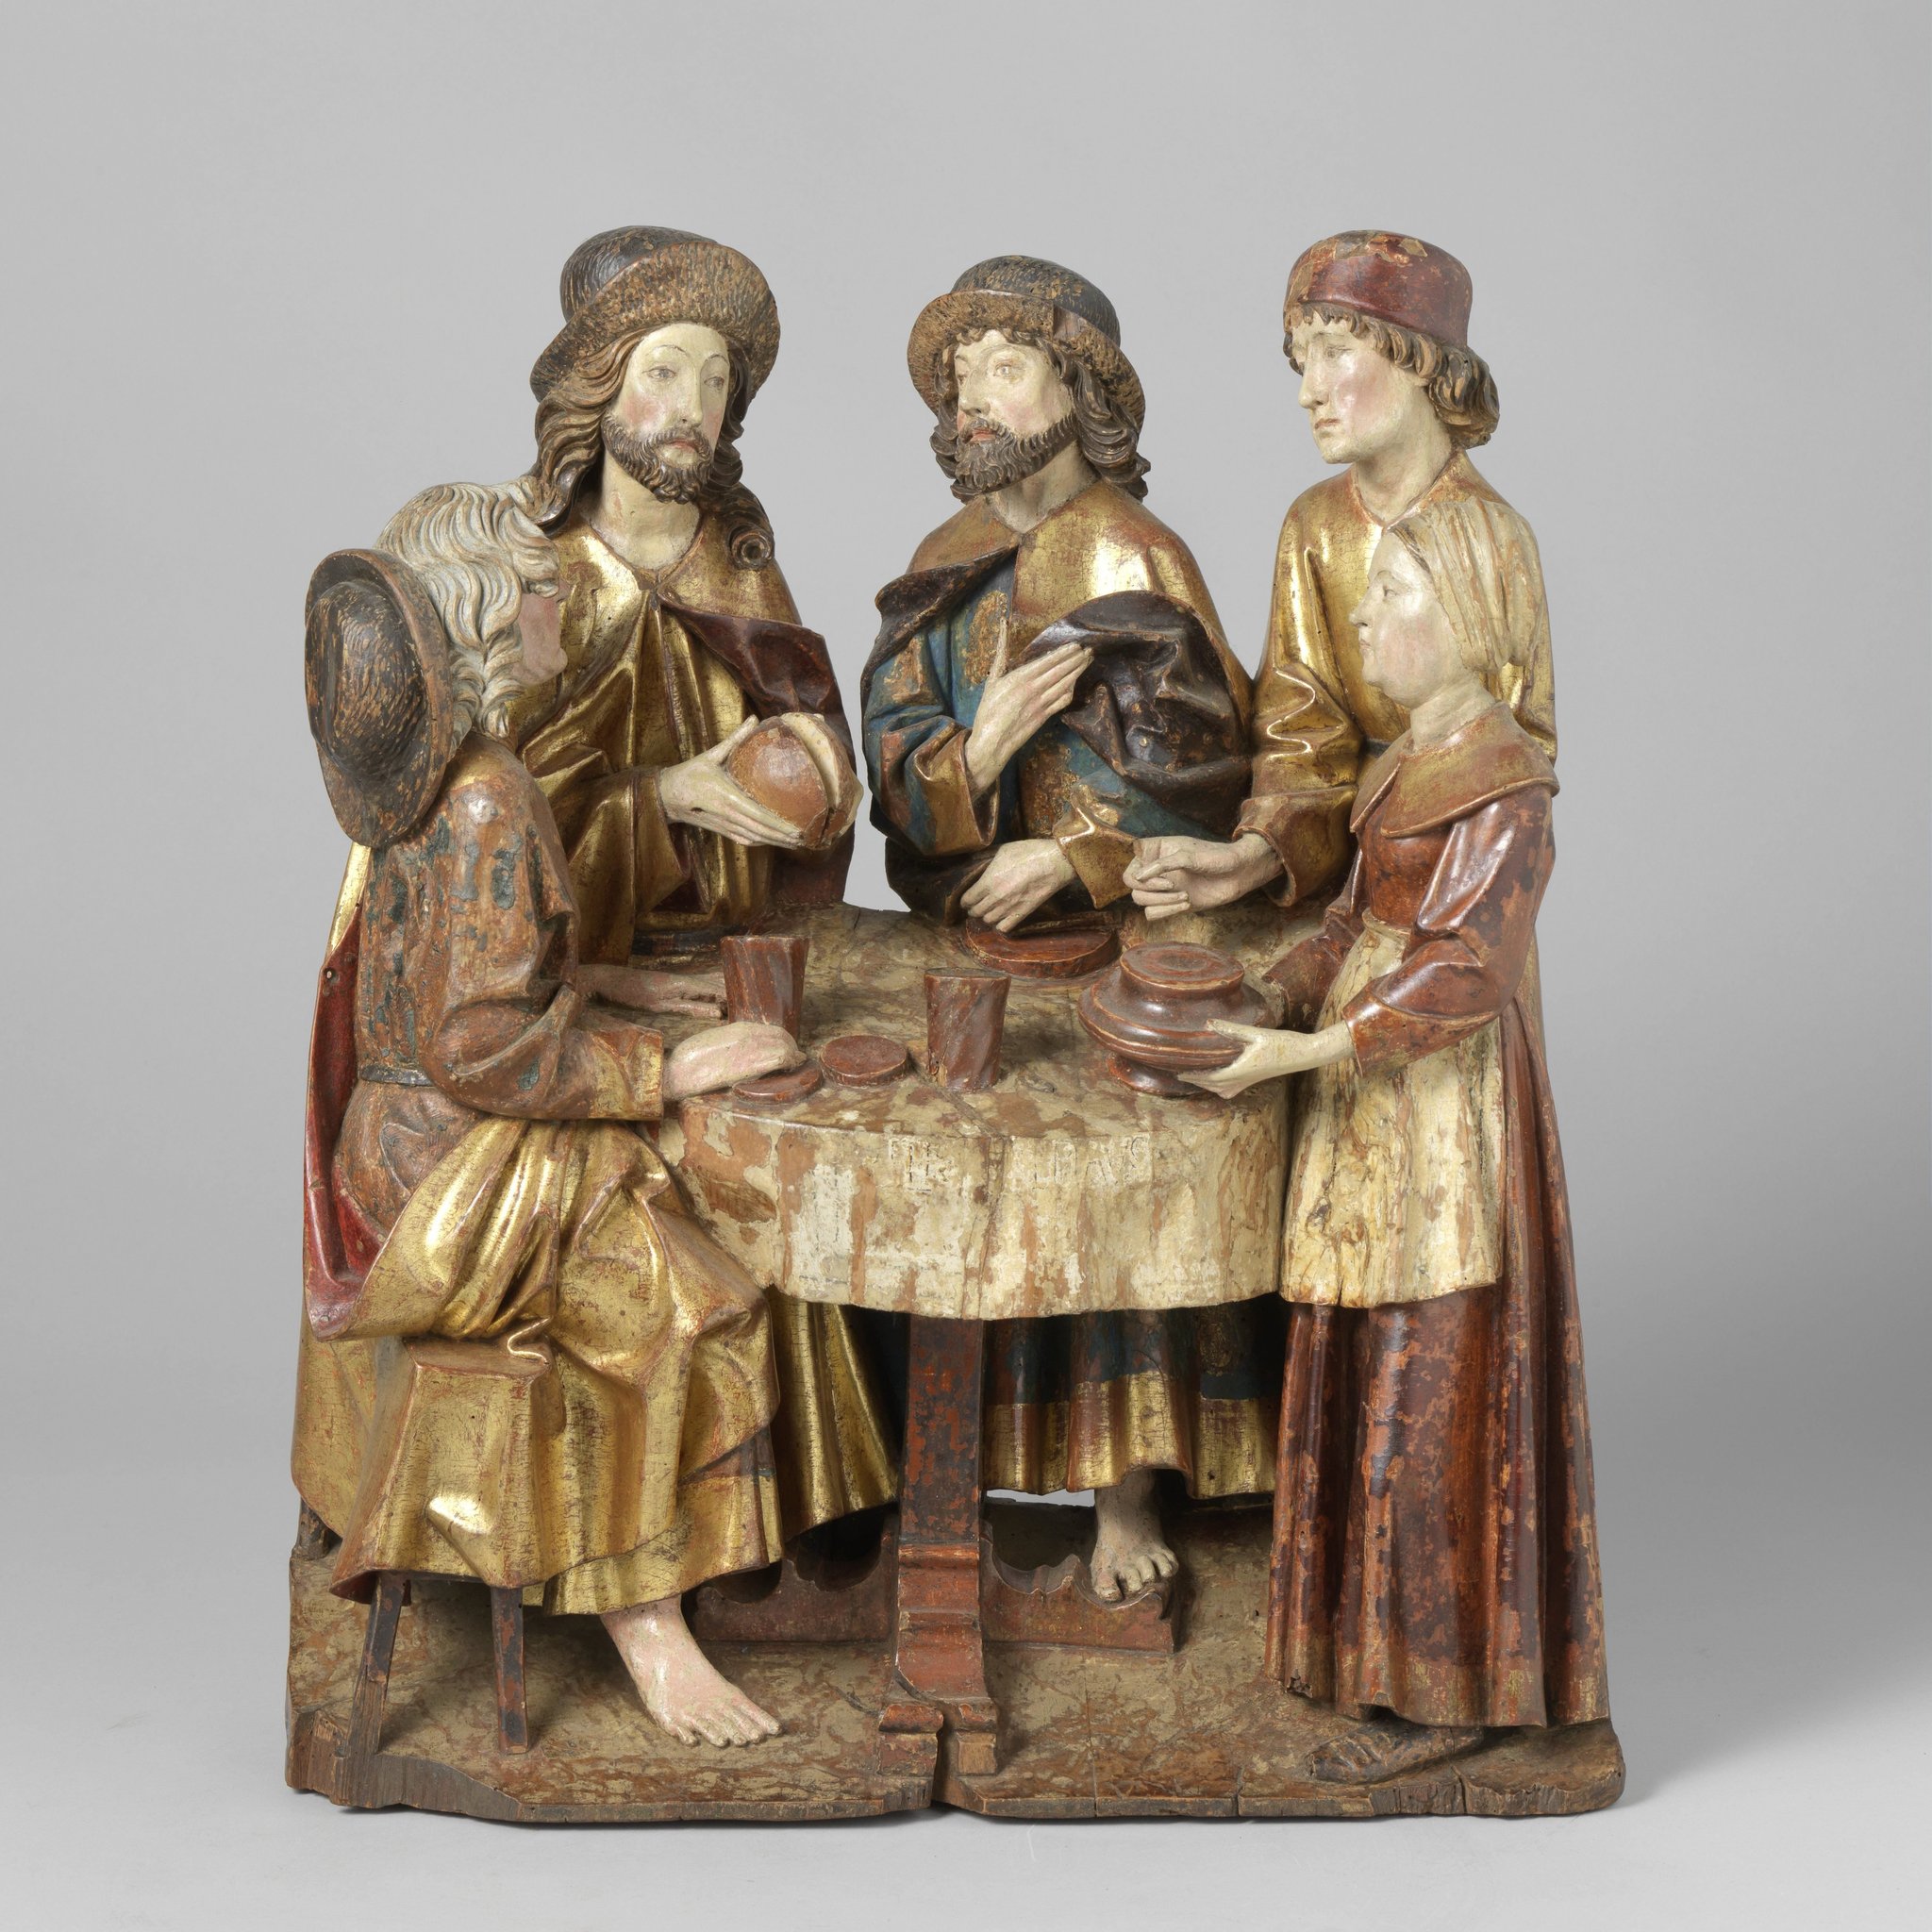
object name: sculpture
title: The Supper at Emmaus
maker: Anonymous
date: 1520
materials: wood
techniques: gilding, polychromy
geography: ulm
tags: the supper at emmaus: christ is recognized while blessing or breaking the bread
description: These three groups depict scenes from the life of Christ in which he appears at a meal table. They would originally have formed part of the predella (lower zone) of a large carved altar. The three table scenes refer to the celebra-tion of Mass, when bread and wine are presented at the altar as the body and blood of Christ.